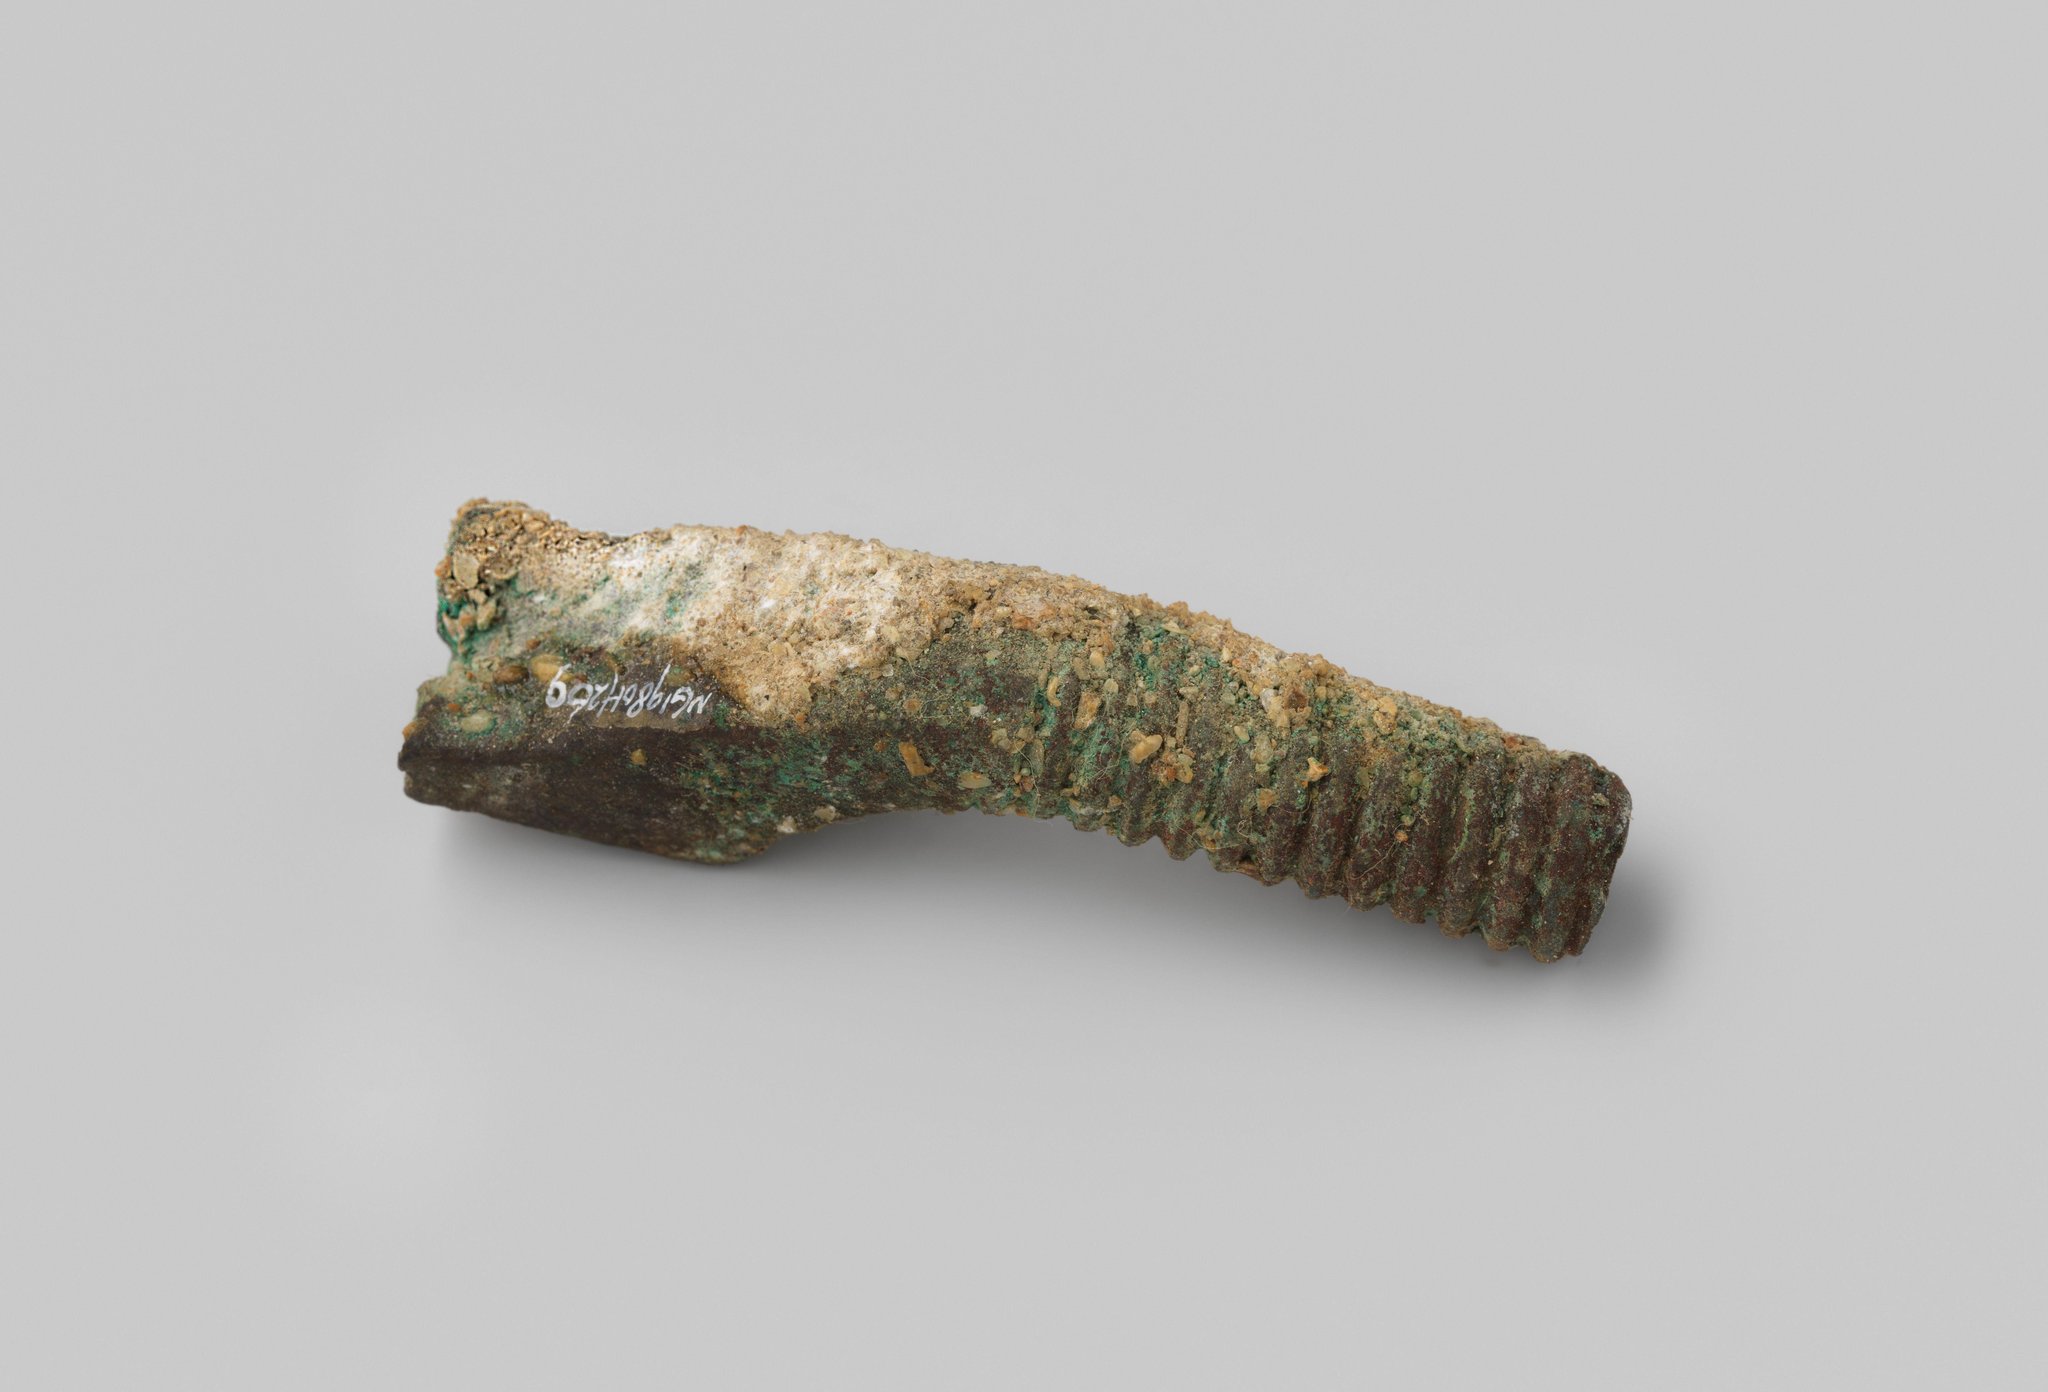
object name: bolt tongs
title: Bout afkomstig uit het wrak van de Oost-Indiëvaarder Hollandia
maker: Anonymous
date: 1700-1743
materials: bronze, copper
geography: netherlands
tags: verenigde oostindische compagnie, hollandia (schip)